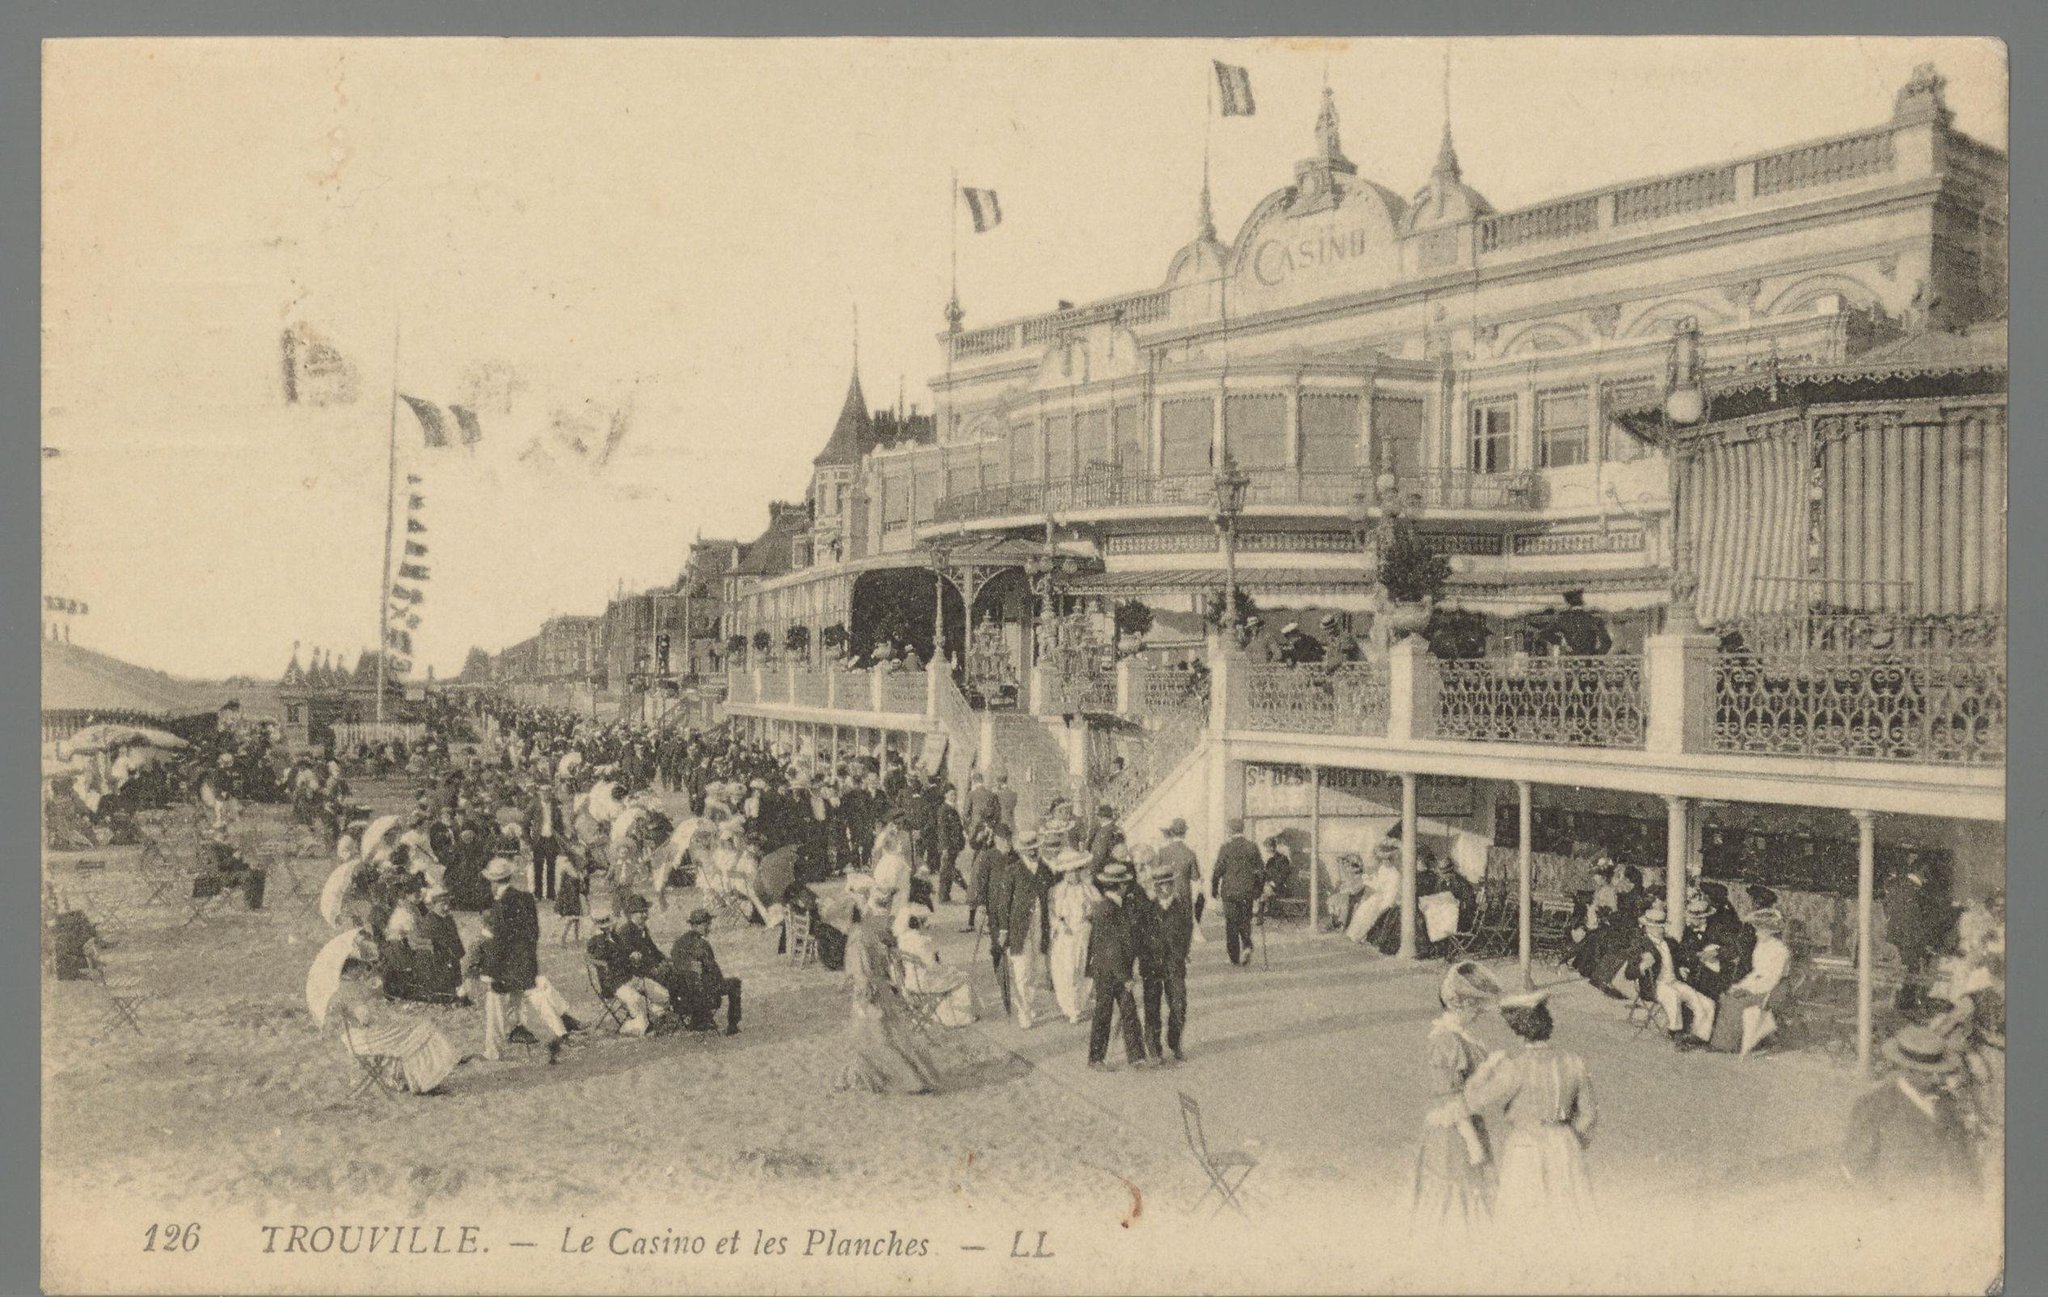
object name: ansichtkaart, prentbriefkaart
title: Trouville. Le Casino et les Planches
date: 1903-1920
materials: cardboard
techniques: photograph, writing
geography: paris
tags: beach (as place of recreation), pleasure-resort, casino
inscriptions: postage stamp